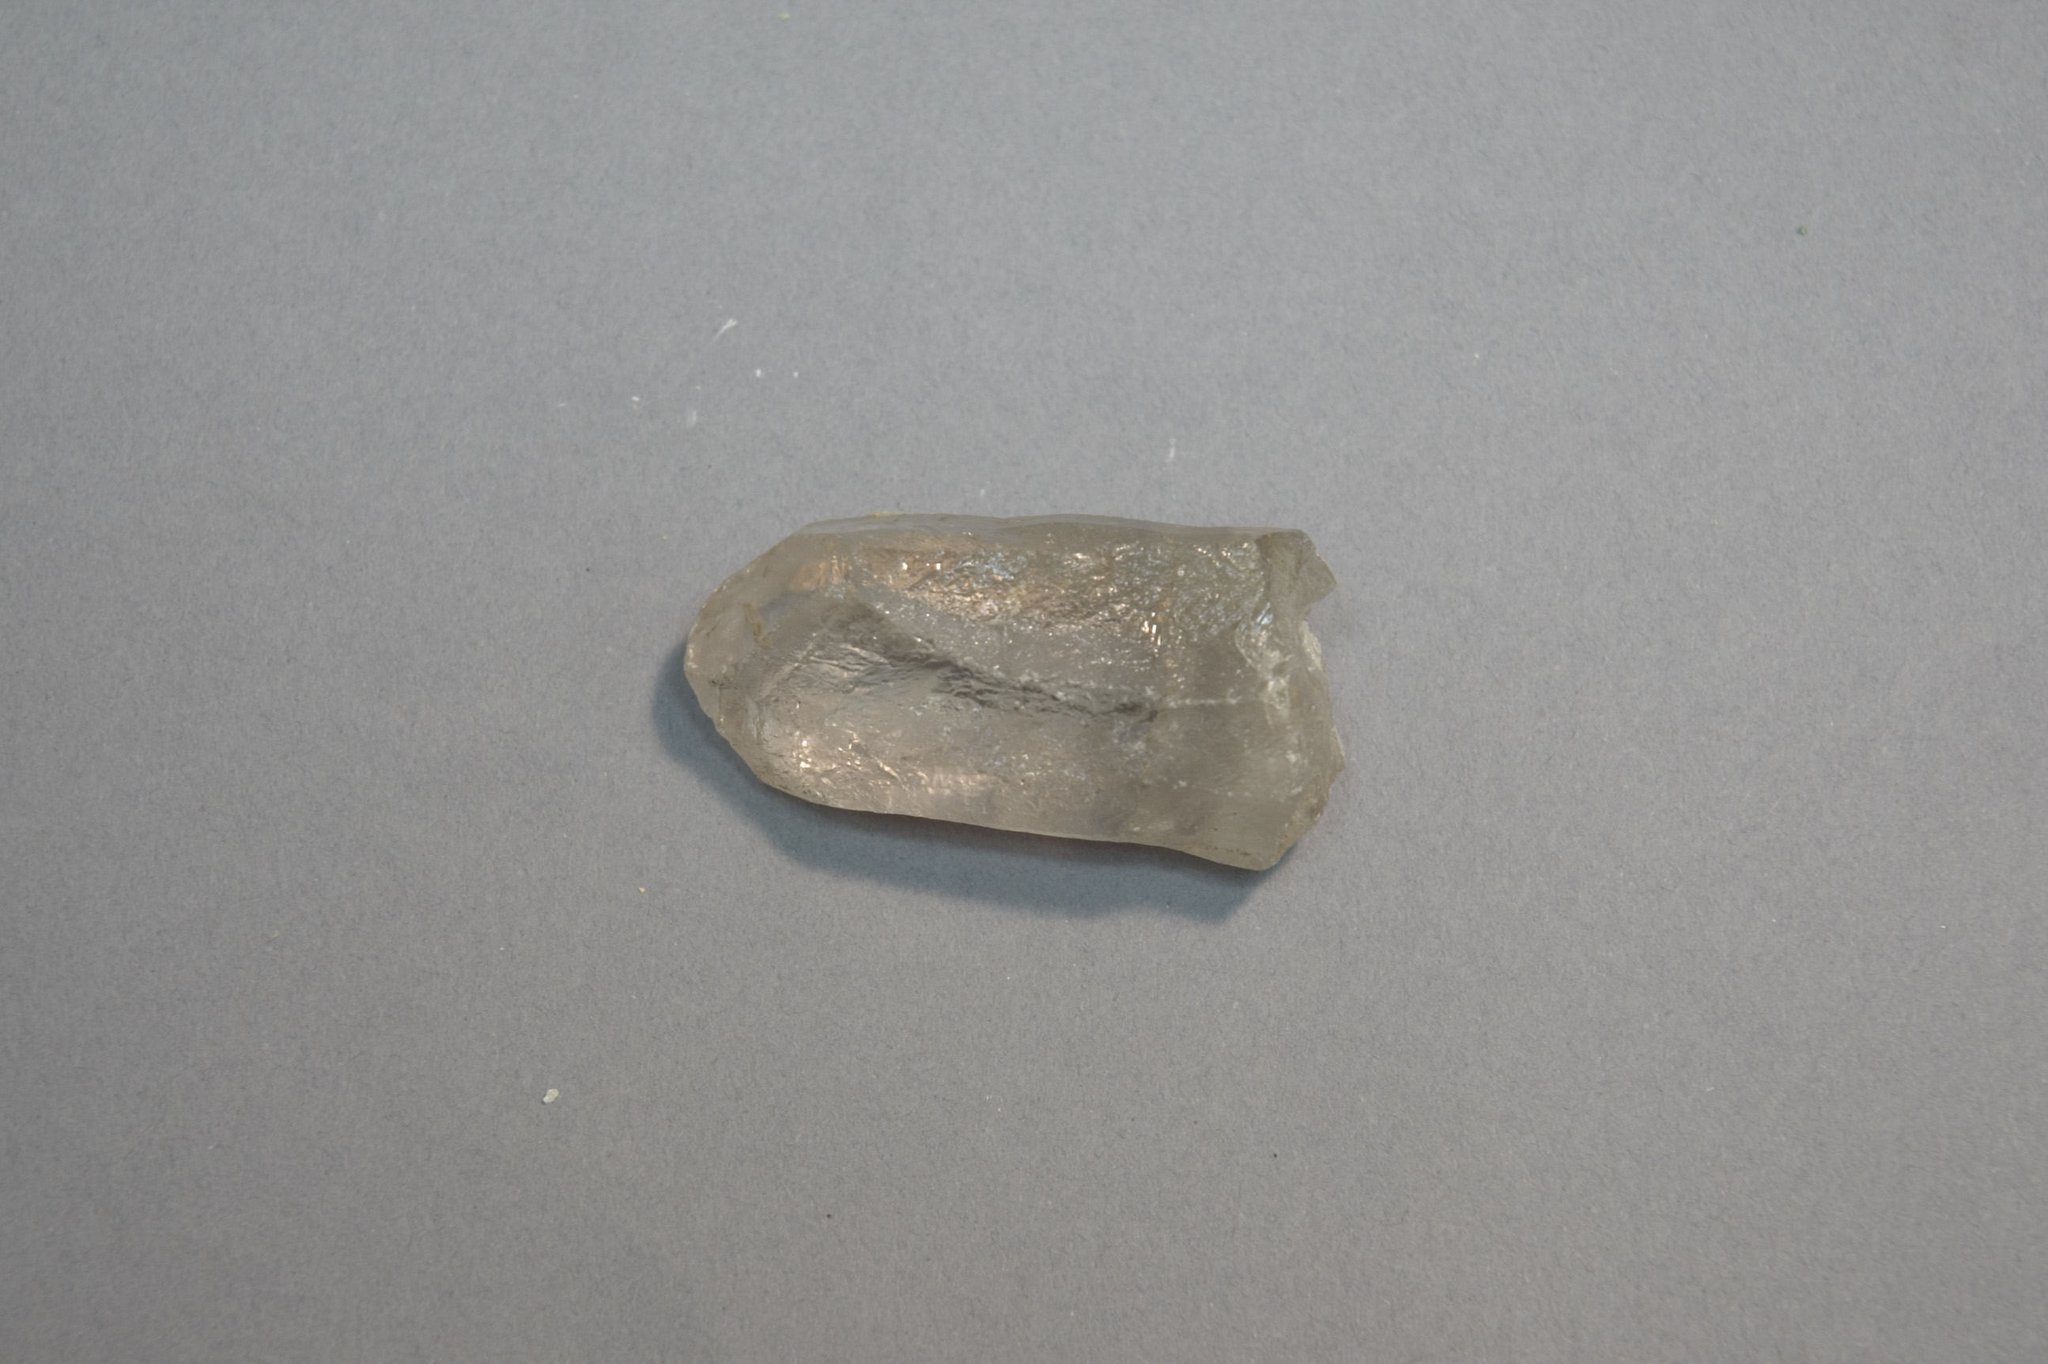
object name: jade carving material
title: Sample of Rock Crystal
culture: chinese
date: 1901-2000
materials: quartz